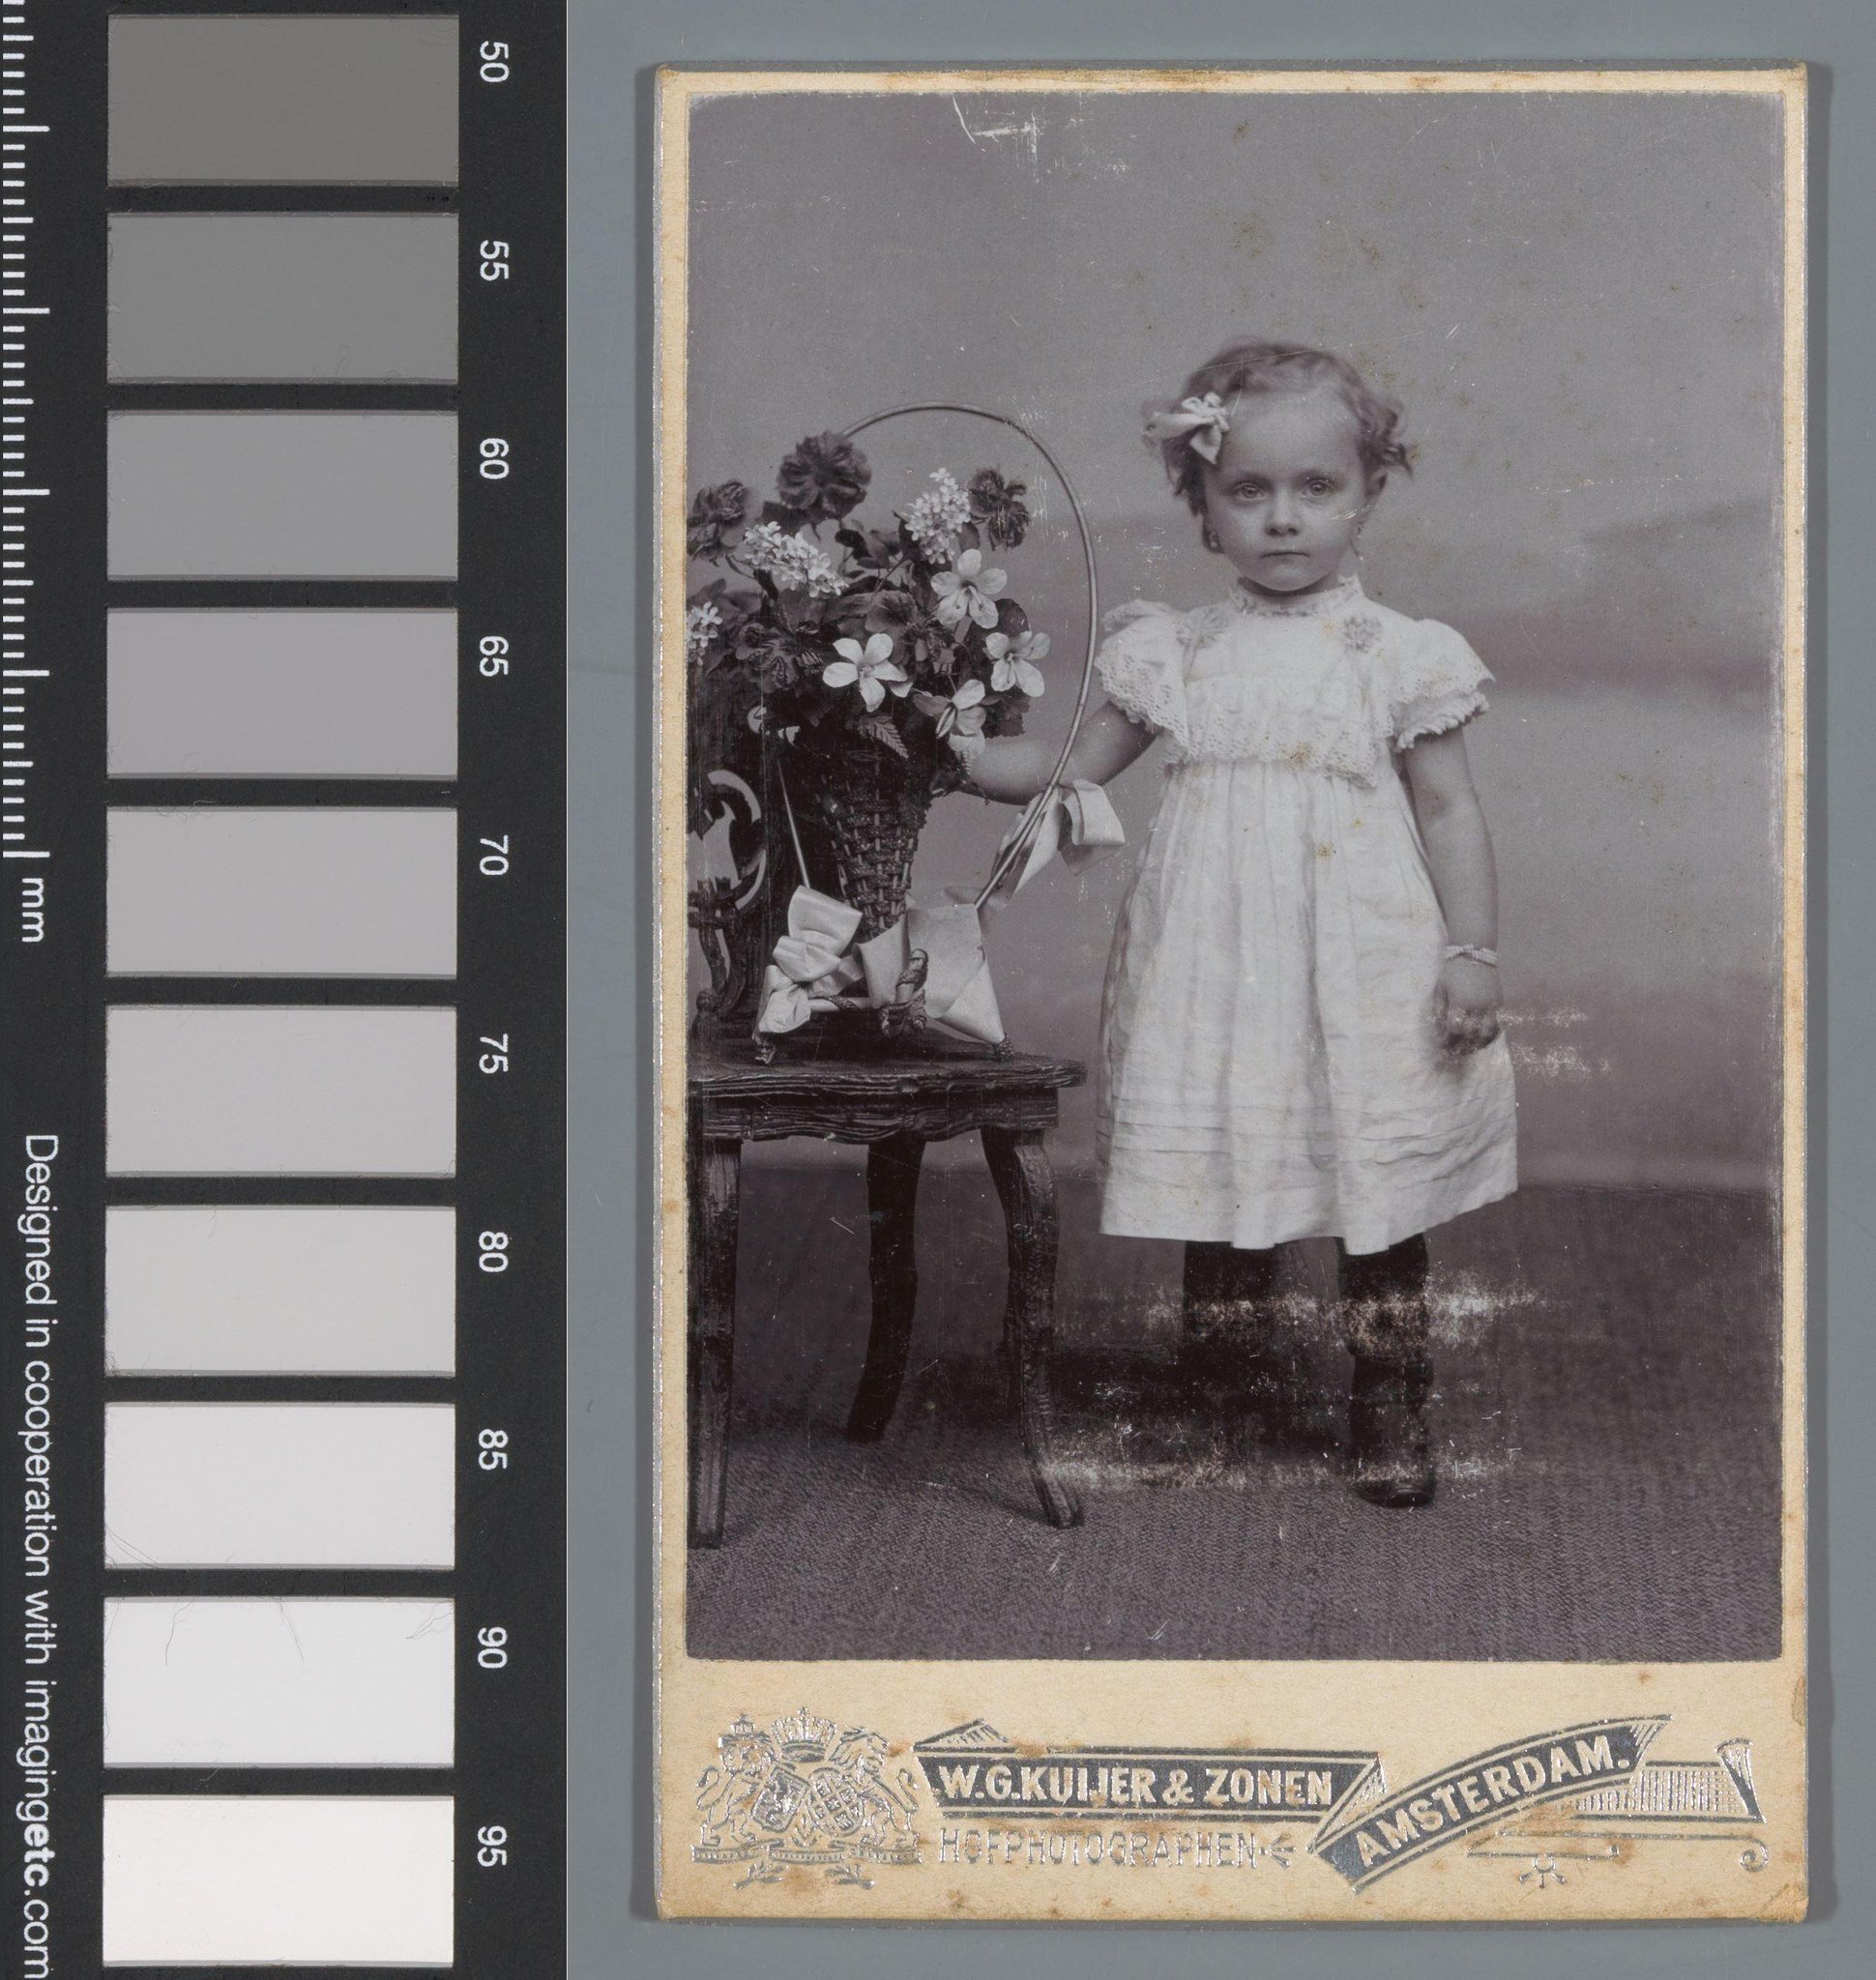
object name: photograph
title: Portret van een onbekend meisje met een bloemenmand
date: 1884-1906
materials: cardboard, photographic support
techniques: collodion silver print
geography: amsterdam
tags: cut flowers; nosegay, bunch of flowers, historical persons, girl (child between toddler and youth)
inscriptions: inscription: ‘OPGERICHT 1864/ W. G. Kuijer & Zonen/ Hofphotographen/ WESTERMARKT 19./ 14/ AMSTERDAM/ Spéciale Inrichting voor Vergrootingen in alle Formaten.’